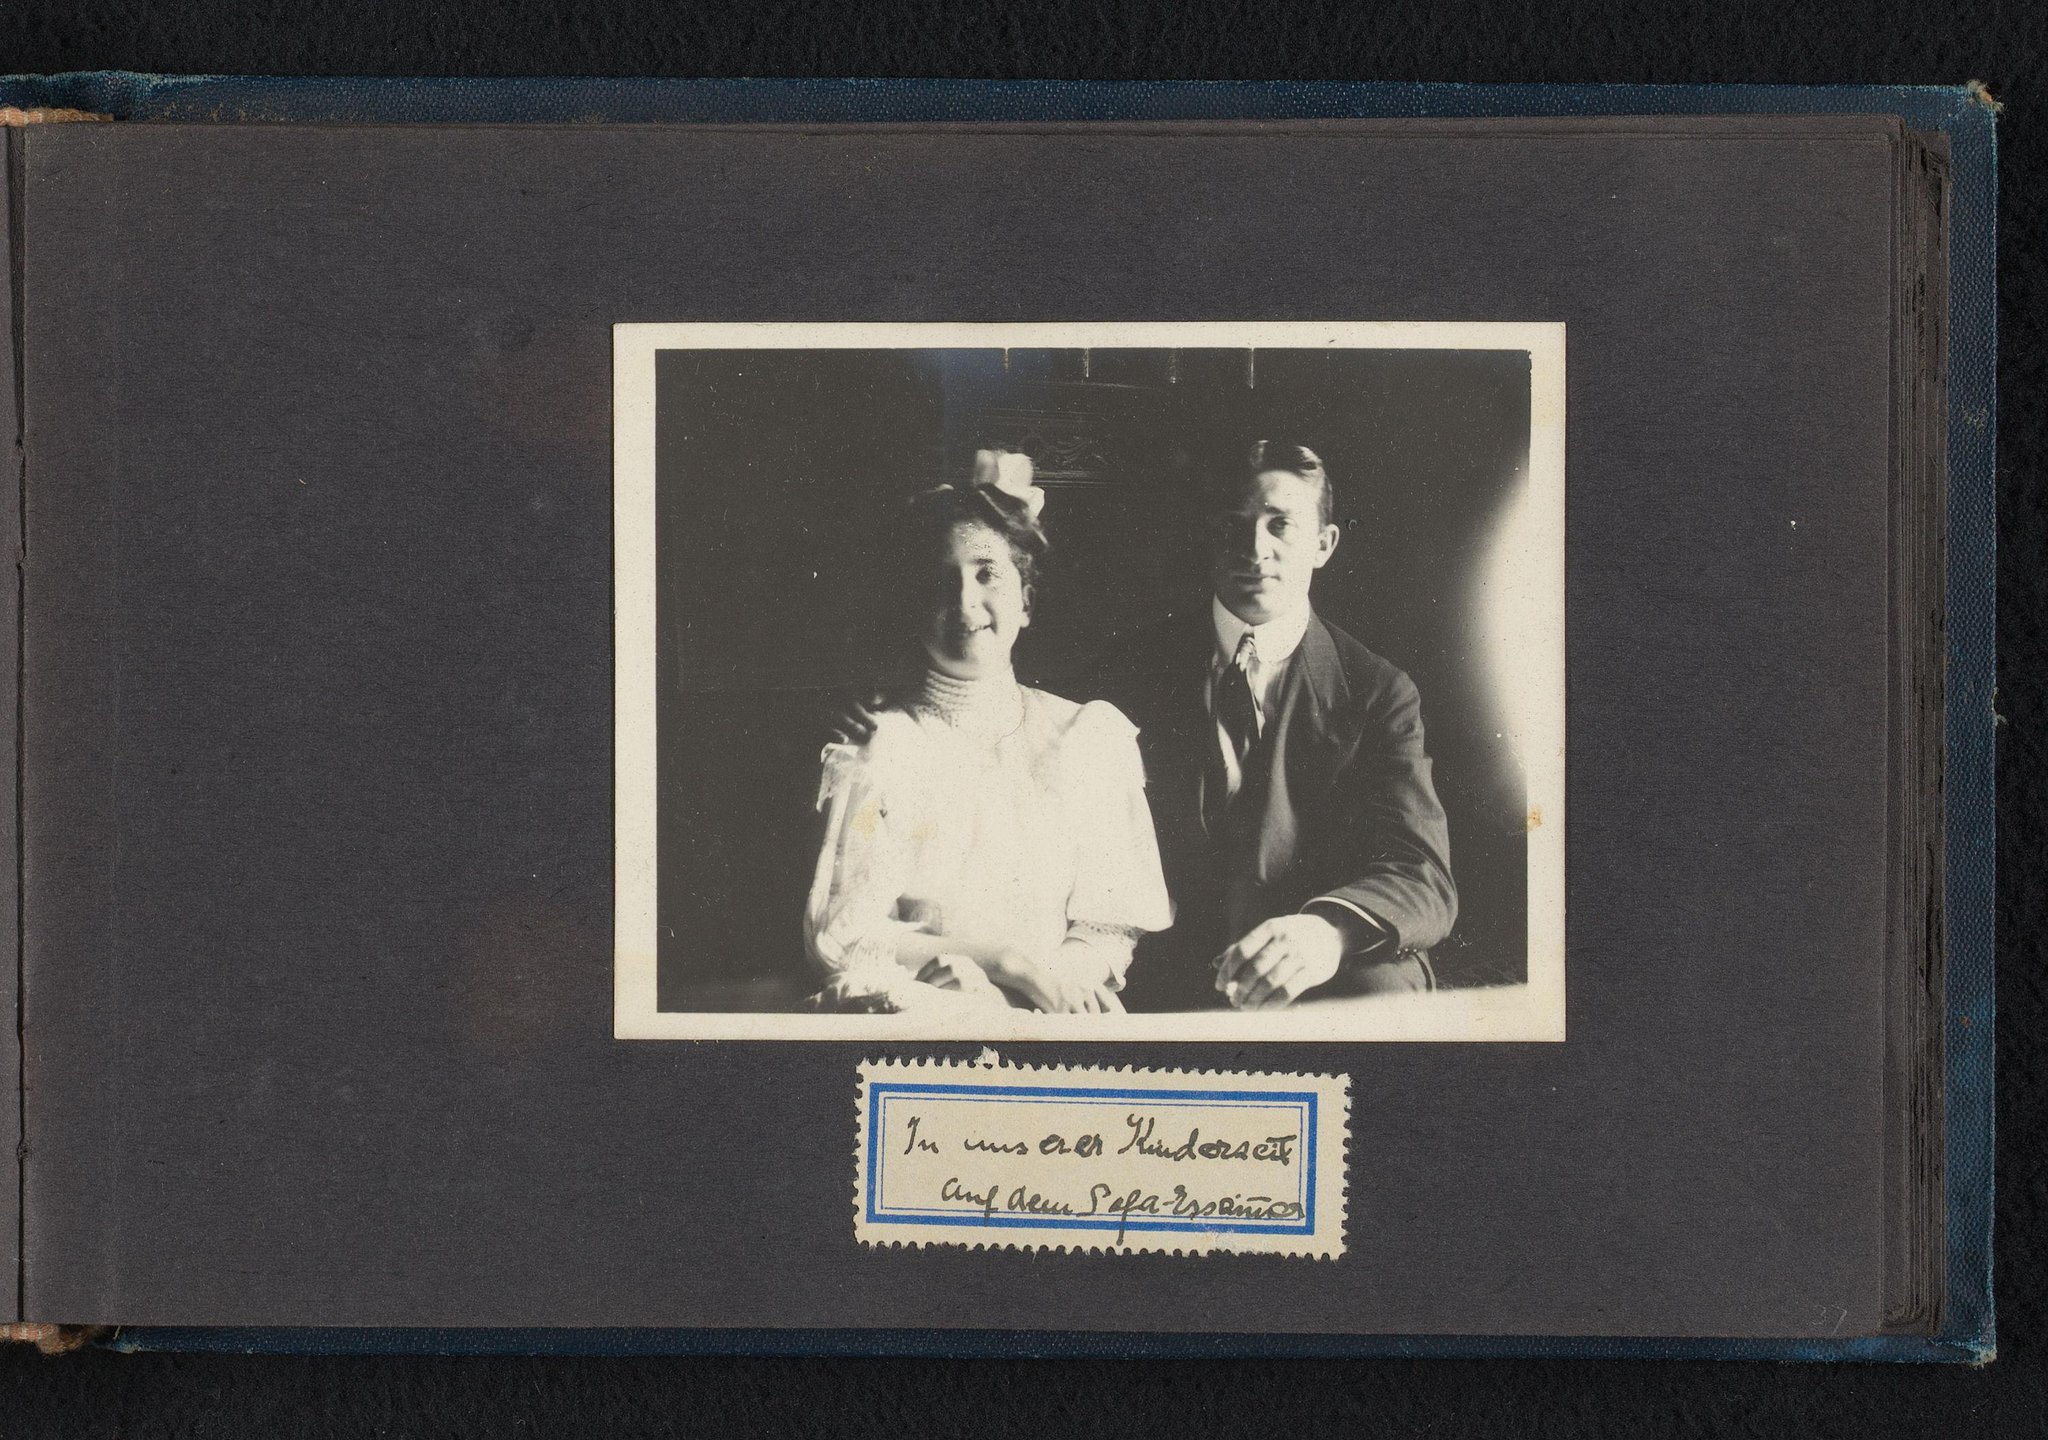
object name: photograph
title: Else en Willy Moos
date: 1913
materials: paper, photographic support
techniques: gelatin silver print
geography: germany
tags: else wachenheimer-moos, willy moos, historical persons - bb - woman, historical persons, germany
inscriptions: inscription: ‘In unserer Kinderzeit auf dem Sofa-...’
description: Albumblad met een foto van Else en Willy Moos, uit hun kindertijd, voor zijn vertrekt naar China. Onderdeel van het fotoalbum van Else Wachenheimer-Moos en haar broers Arthur en Willy Moos en anderen in de periode 1913-1918.